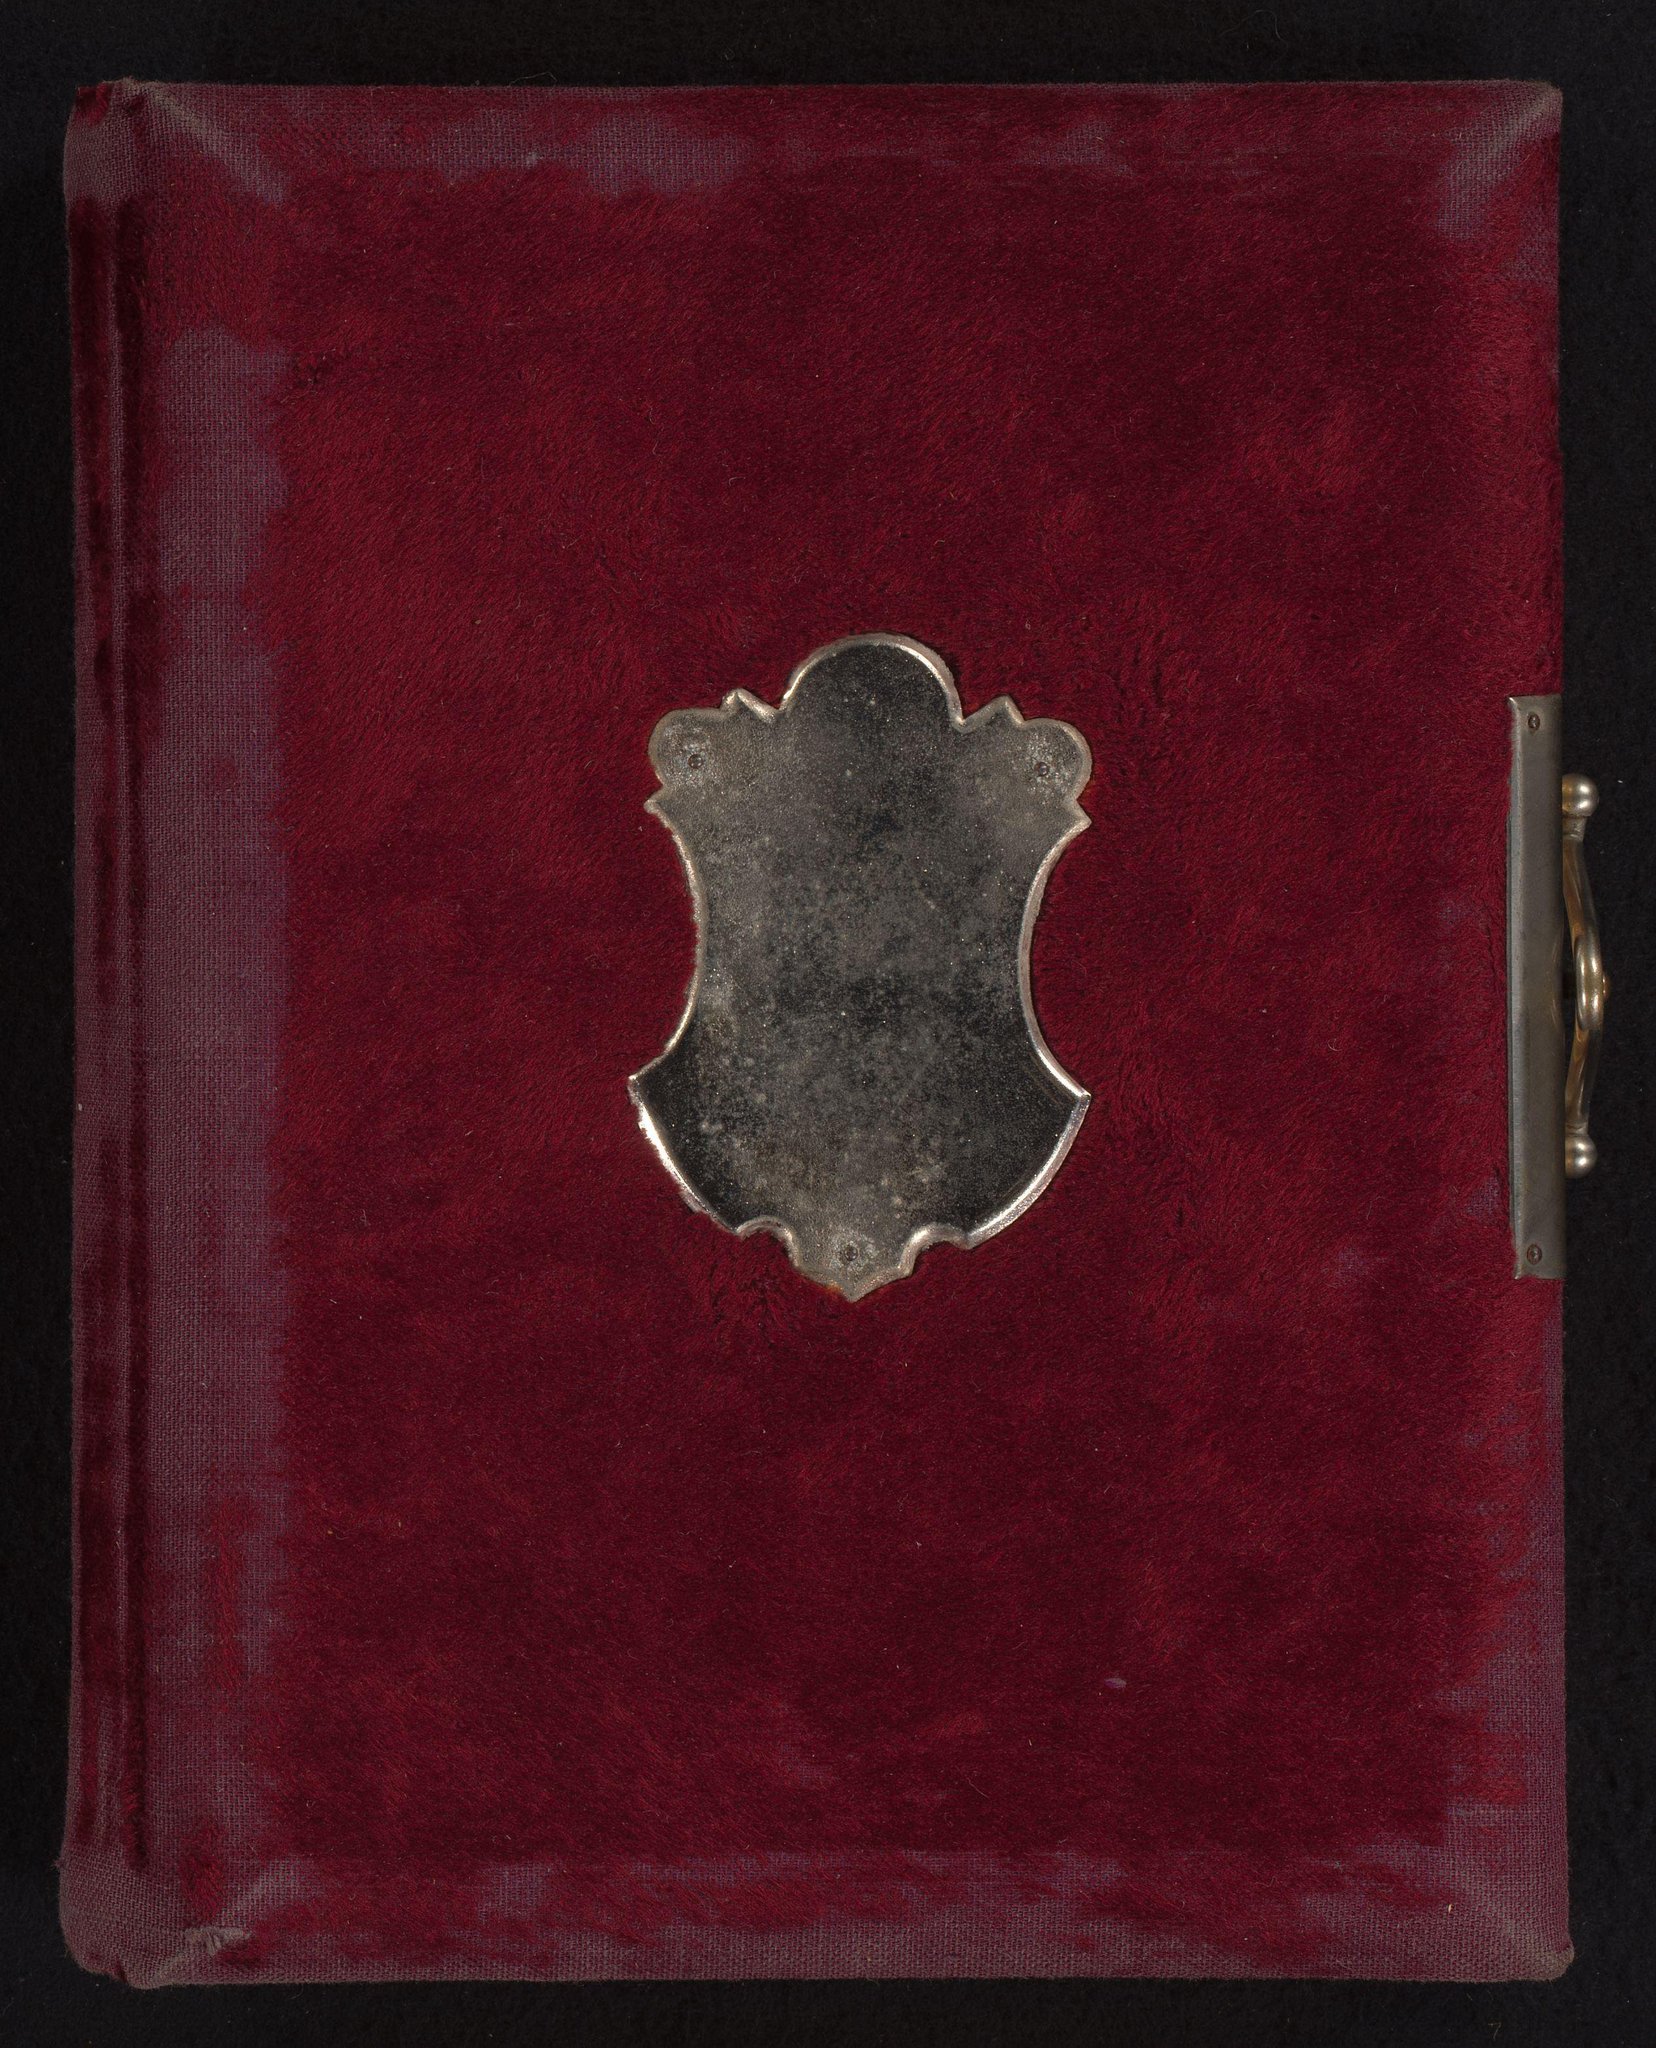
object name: slip in album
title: Nederlands familiealbum met 72 portretten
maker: Anonymous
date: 1860-1900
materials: cardboard, metal, paper, photographic support, velvet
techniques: albumen print, chromolithography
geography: netherlands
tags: historical persons - bb - woman, child, historical persons, piece of sculpture, reproduction of a piece of sculpture, dog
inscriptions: collector's mark: ‘DIENST/ VERSPREIDE/ RIJKSKOLLEKTIES/ (...) A 865’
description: Fotoalbum met in totaal 68 foto's en 4 prenten op 40 pagina's. Het album bevat 12 kabinetfoto's en 56 cartes-de-visite in met gouden lijnen omkaderde passe-partouts en 4 losse chromolitho's achterin het album. Iedere pagina bevat ofwel 1 passe-partout voor een kabinetfoto, ofwel naast elkaar in verticale richting 2 passe-partouts voor cartes-de-visite. Afgebeeld zijn portretten van onbekende mannen, vrouwen en kinderen, een foto van een sculptuur, een fotoreproductie van een prent en een foto van een hond. De foto's zijn gemaakt door diverse fotografen in Nederland en Nederlands-Indië, waaronder Albert Greiner, Woodbury & Page en Petz & Co. Van 13 foto's en de 4 prenten is de fotograaf anoniem.